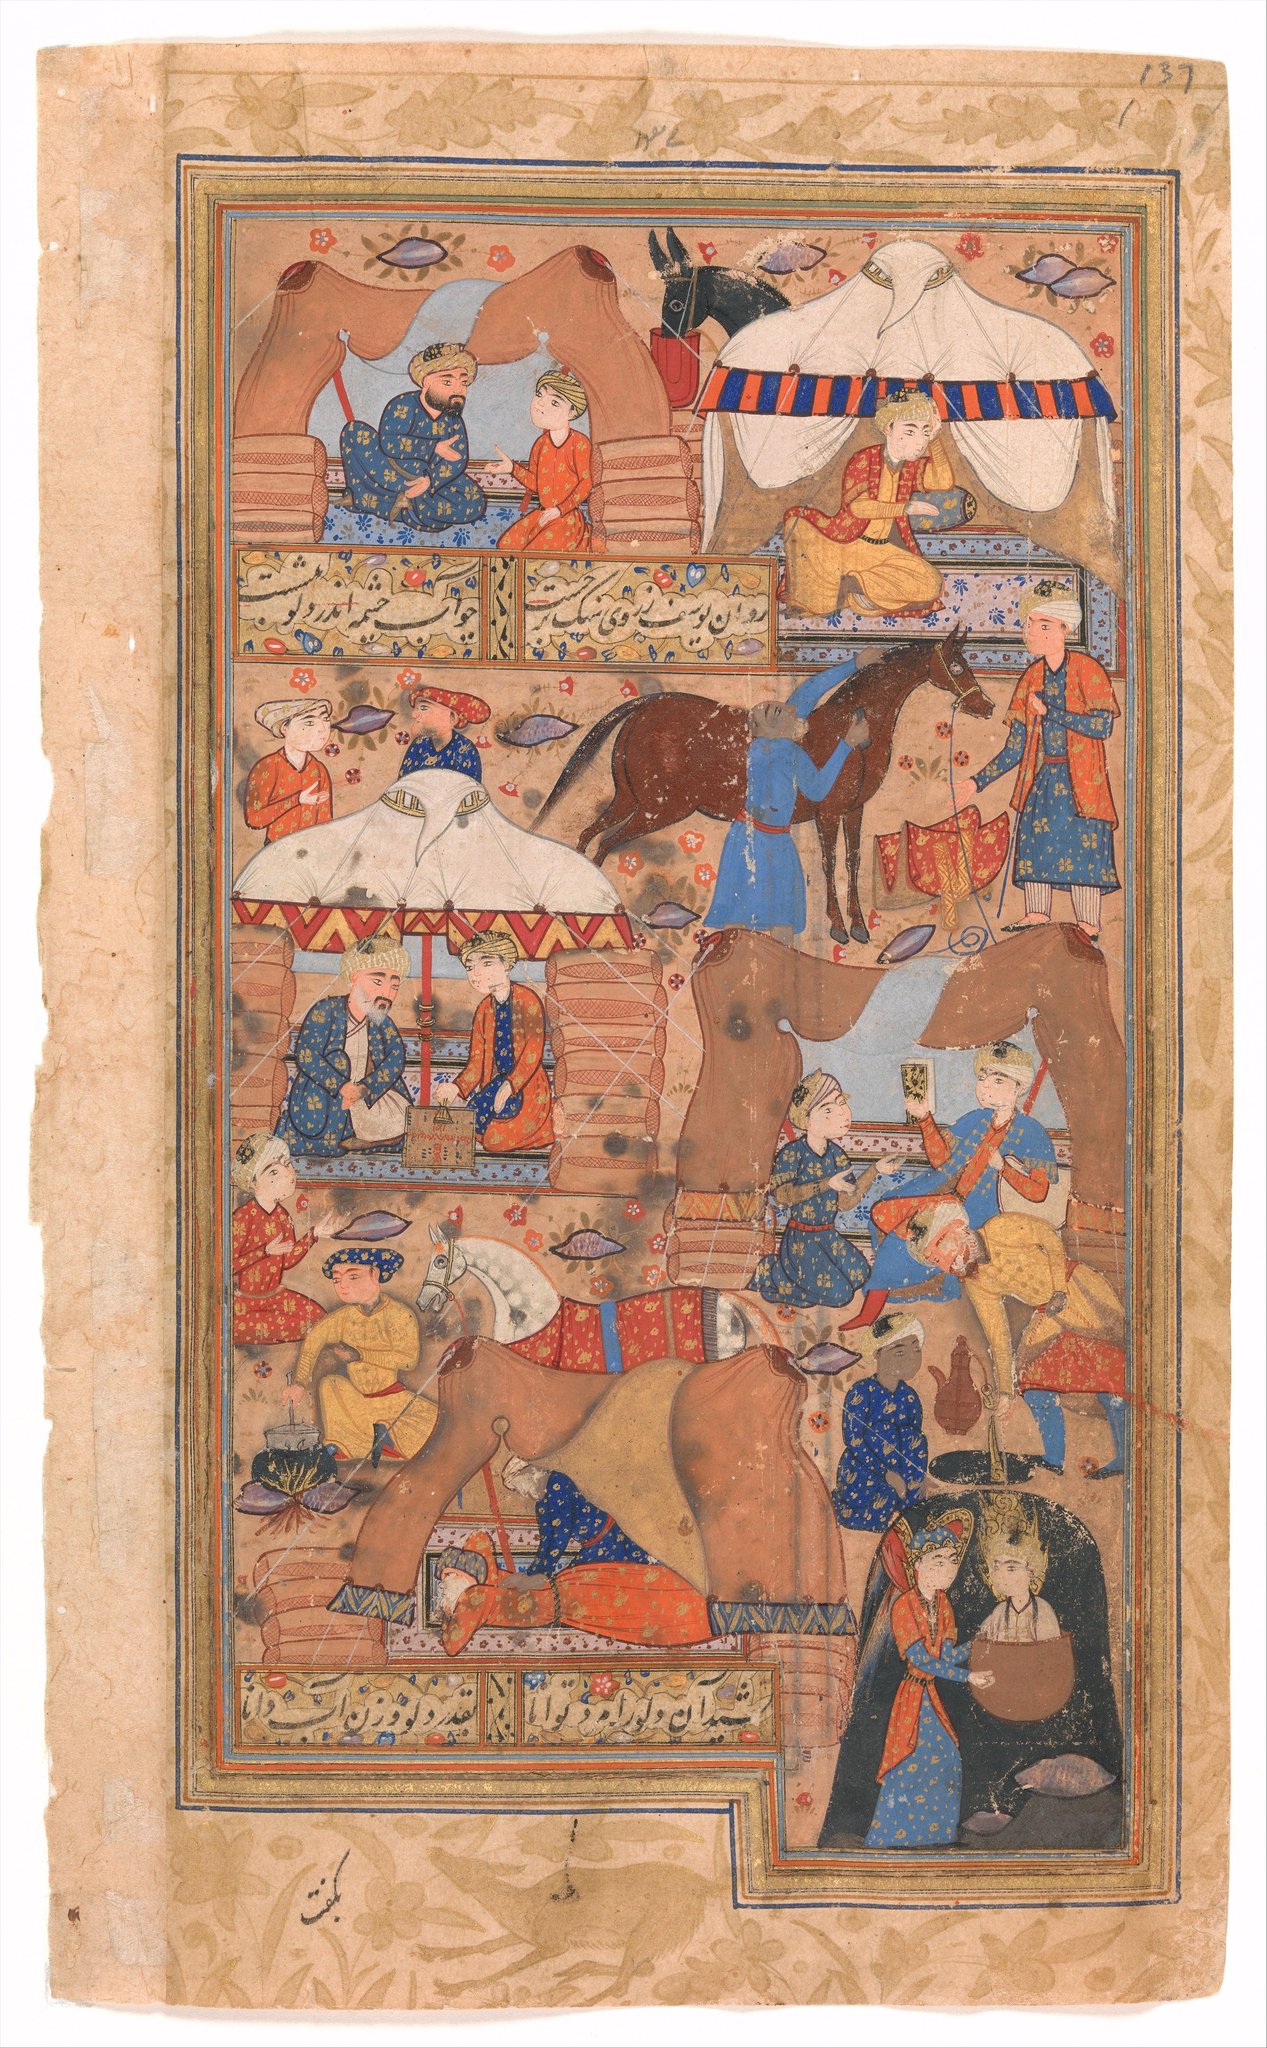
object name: folio from an illustrated manuscript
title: "Yusuf is Drawn Up from the Well", Folio from a Yusuf and Zulaikha of Jami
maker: maulana nur al-din `abd al-rahman jami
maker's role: author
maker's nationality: iranian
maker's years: 1414-1492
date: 1551-1600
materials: gold, paper, watercolor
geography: iran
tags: tents,men,horses